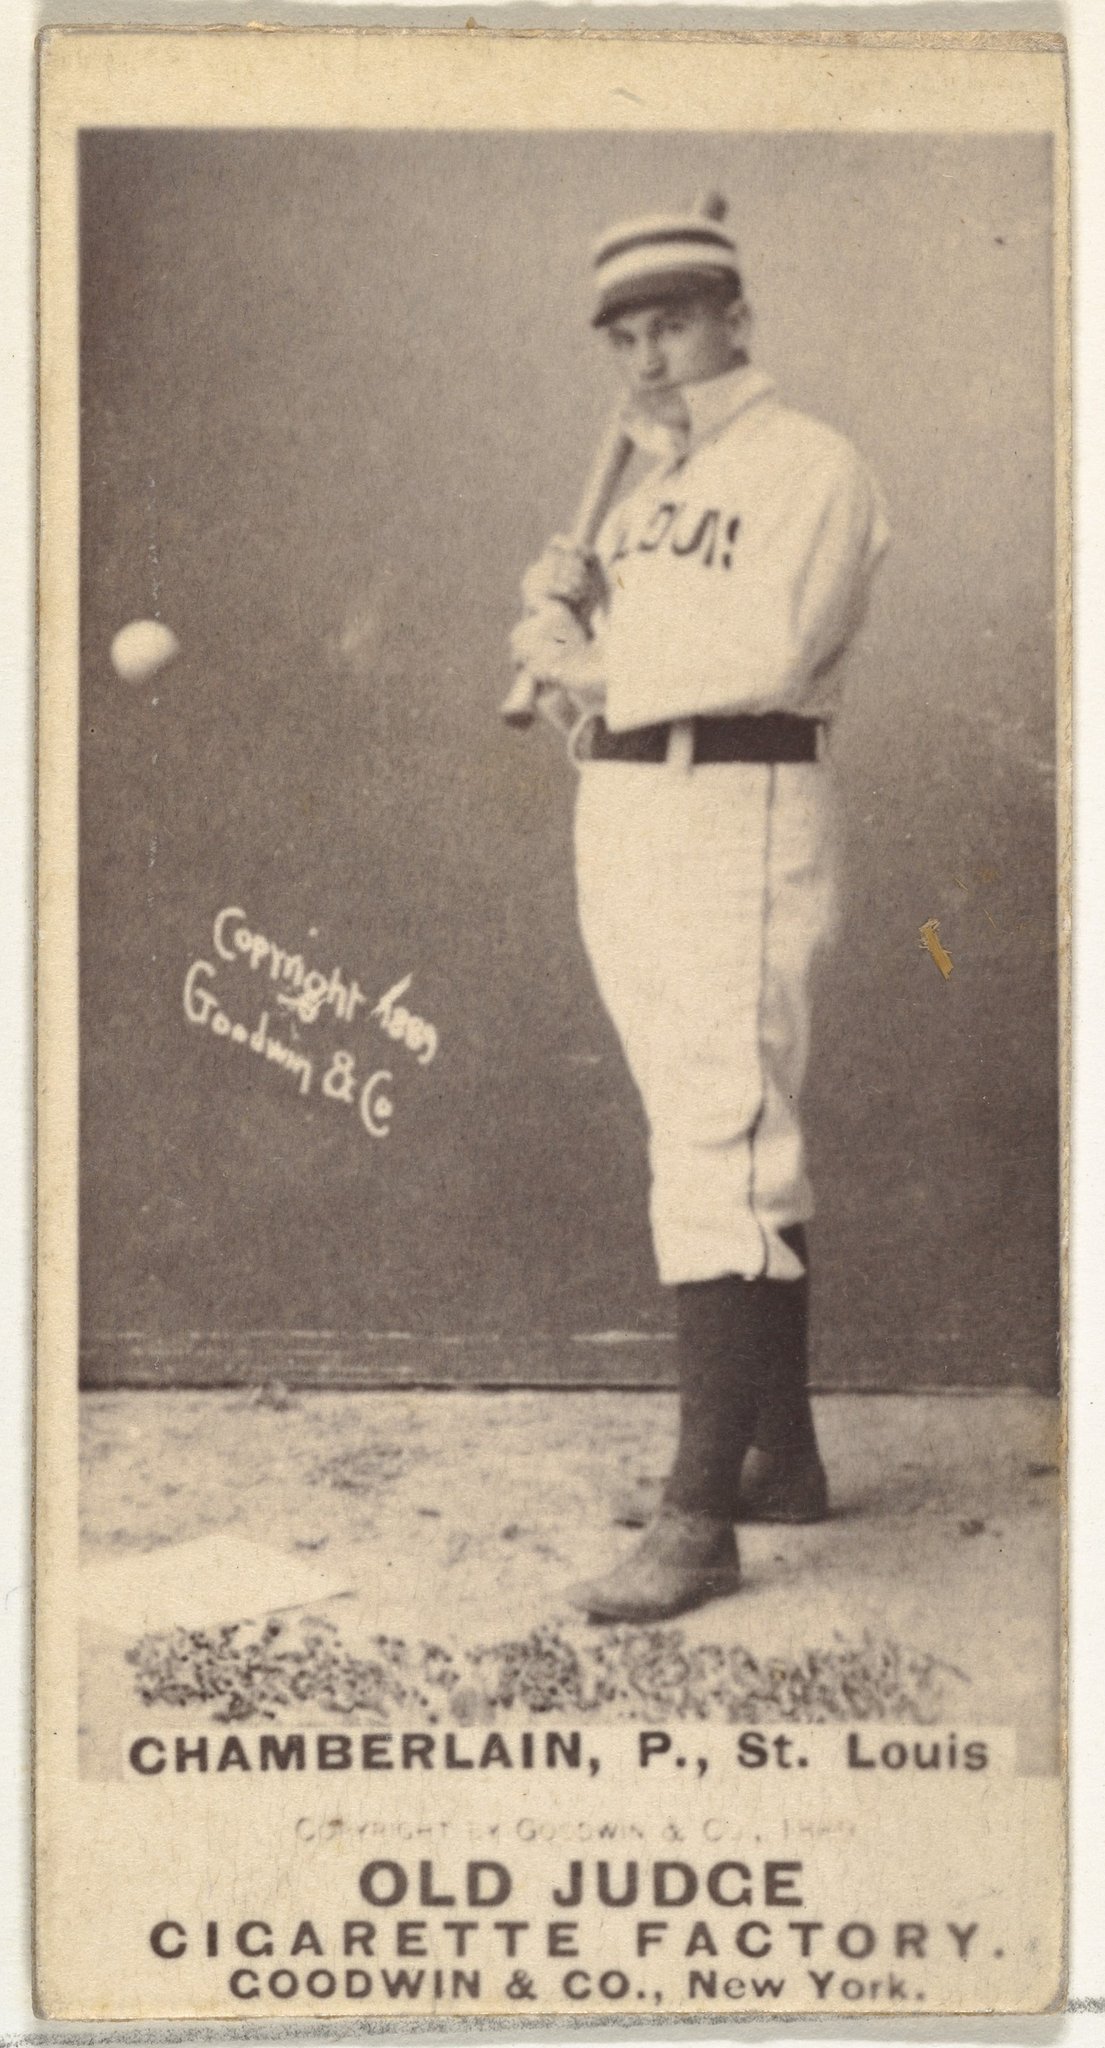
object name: baseball card, photograph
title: Elton P. "Ice Box" Chamberlain, Pitcher, St. Louis Browns, from the Old Judge series (N172) for Old Judge Cigarettes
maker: goodwin & company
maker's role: publisher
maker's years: 1850-1950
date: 1889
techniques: albumen silver print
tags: men,portraits,baseball,athletes